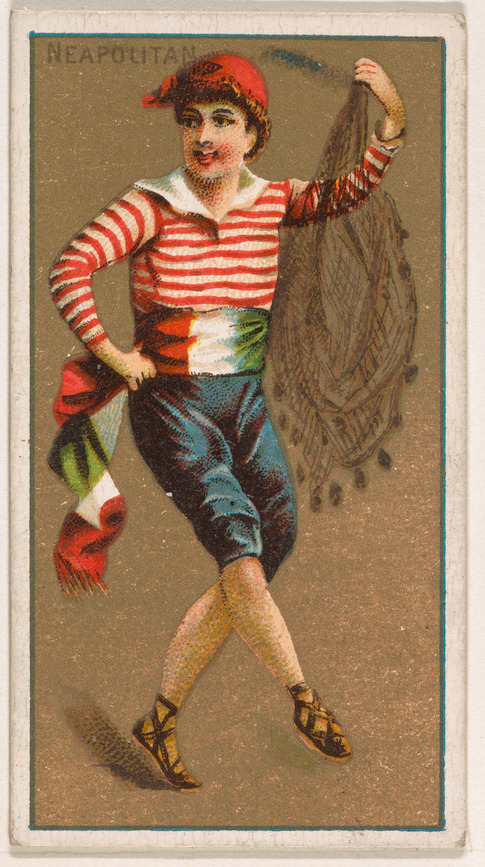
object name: print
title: Neapolitan, from National Dances (N225, Type 1) issued by Kinney Bros.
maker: kinney brothers tobacco company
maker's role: publisher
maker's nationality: american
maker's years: 1869-2011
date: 1889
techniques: color lithograph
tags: women,dancing,dancers